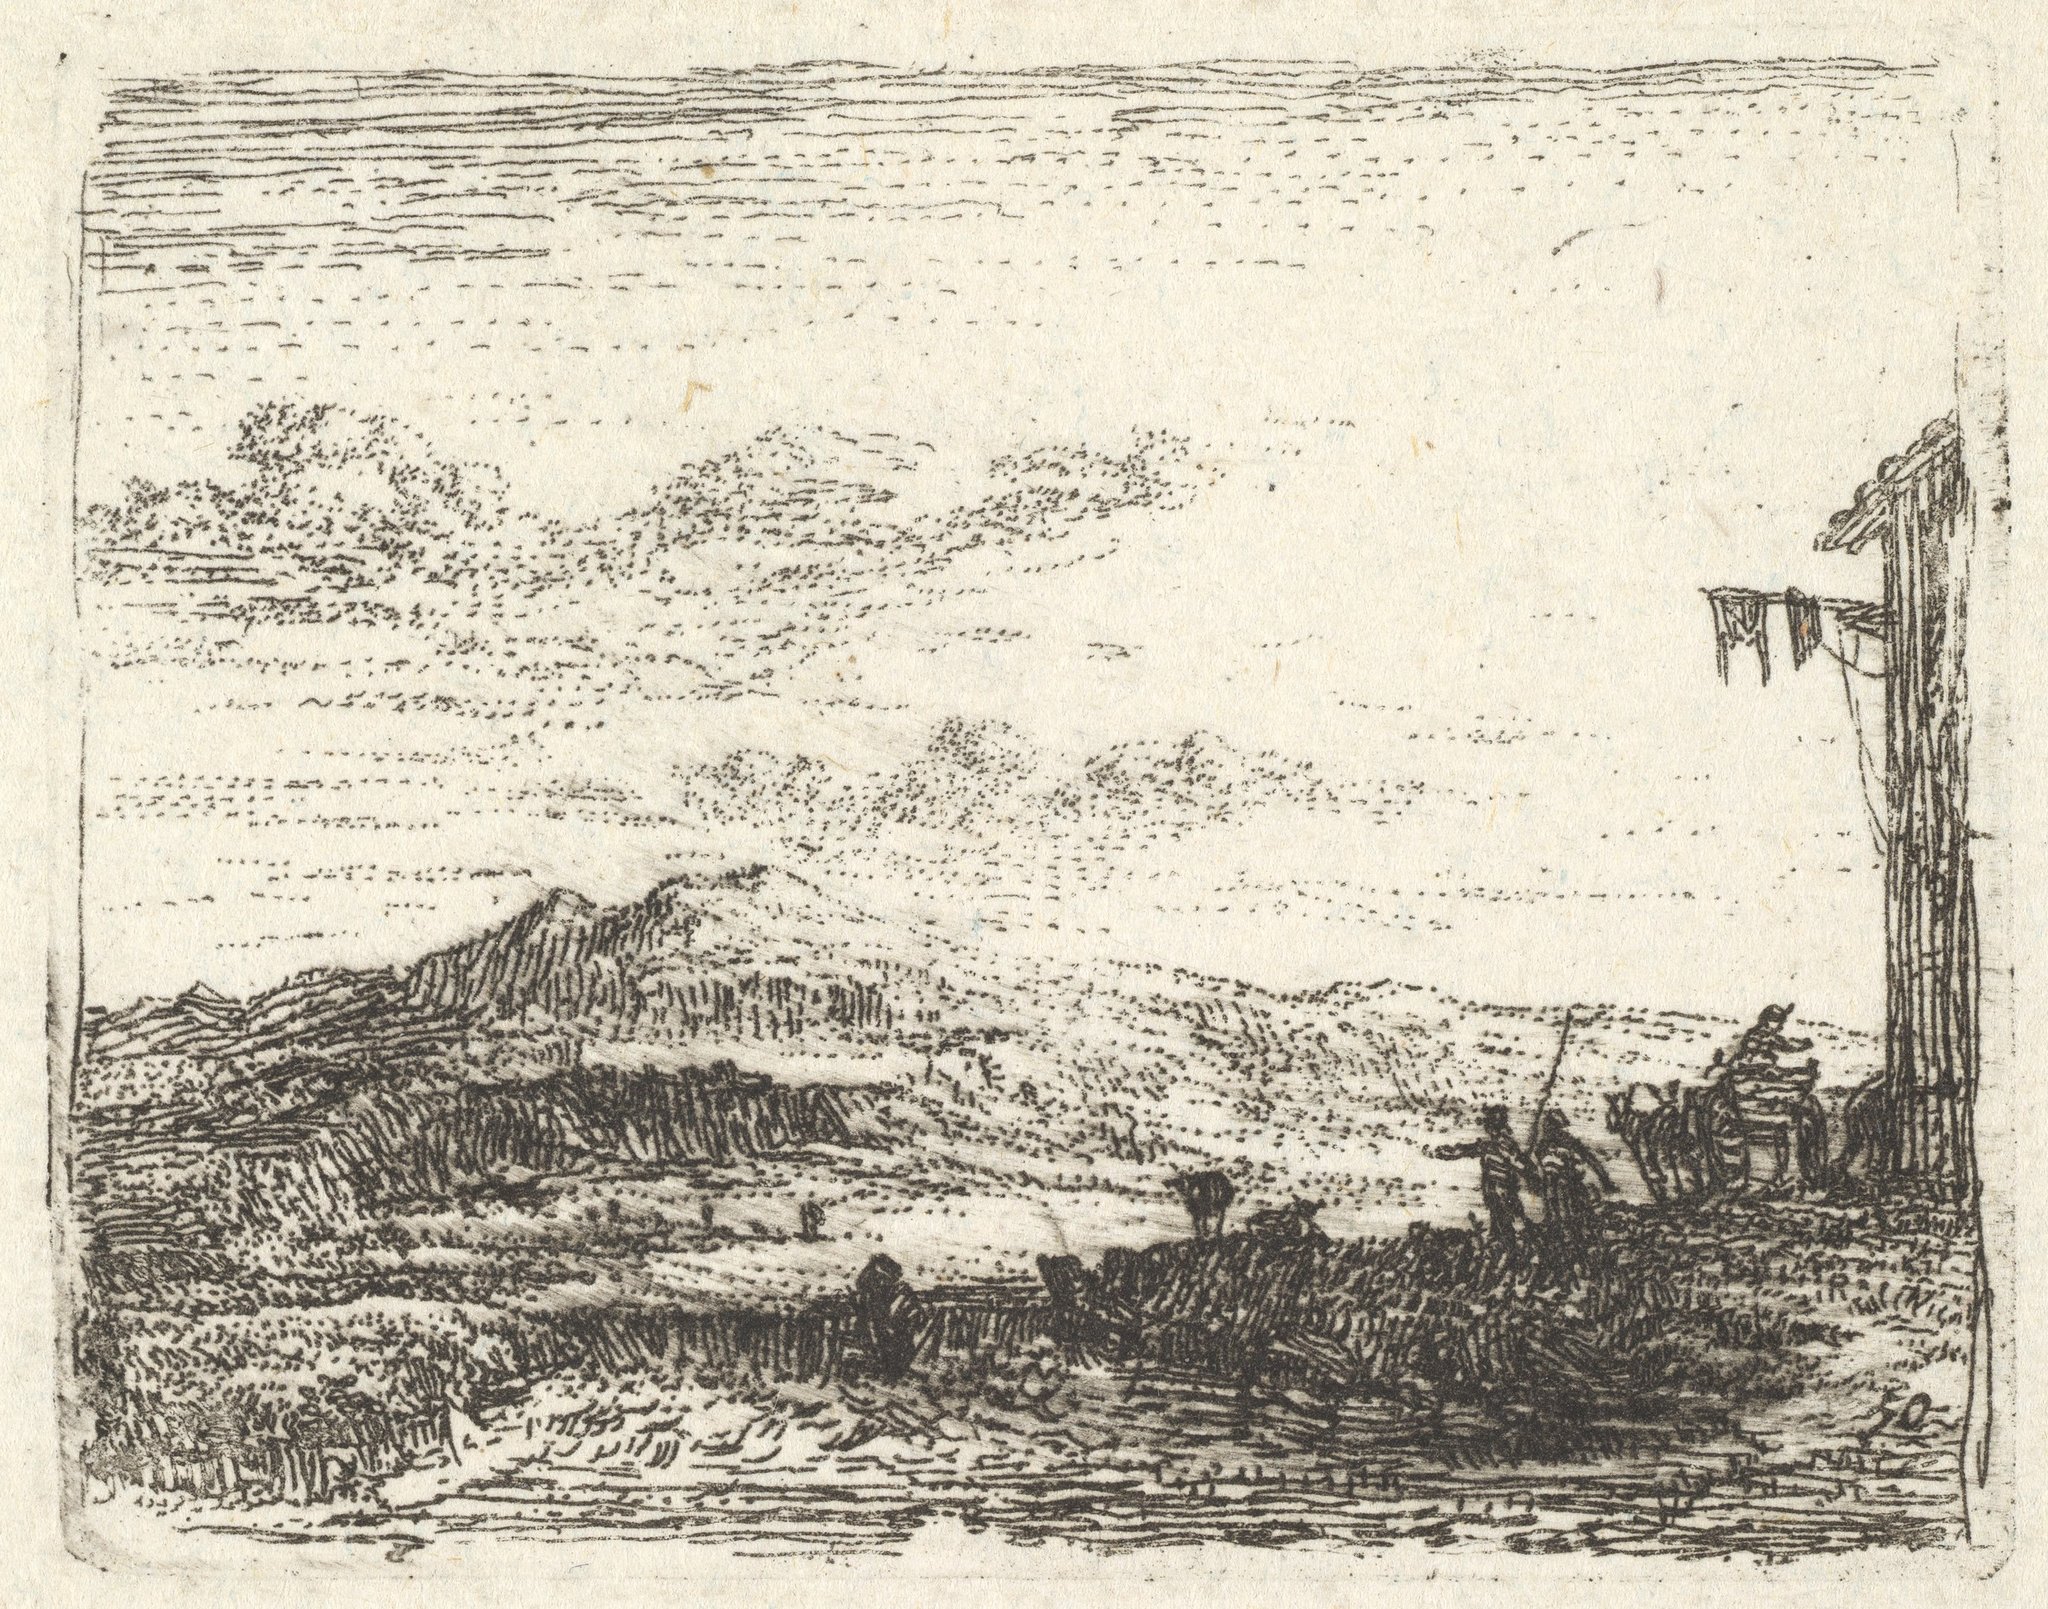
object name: print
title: Landscape with corner of building and awning at far right, two figures and a horse-drawn cart are positioned with backs toward the building, a craggy hill beyond, from "The Small Landscapes"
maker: karel dujardin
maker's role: artist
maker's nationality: dutch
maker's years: 1622-1678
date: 1641-1678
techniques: etching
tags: landscapes